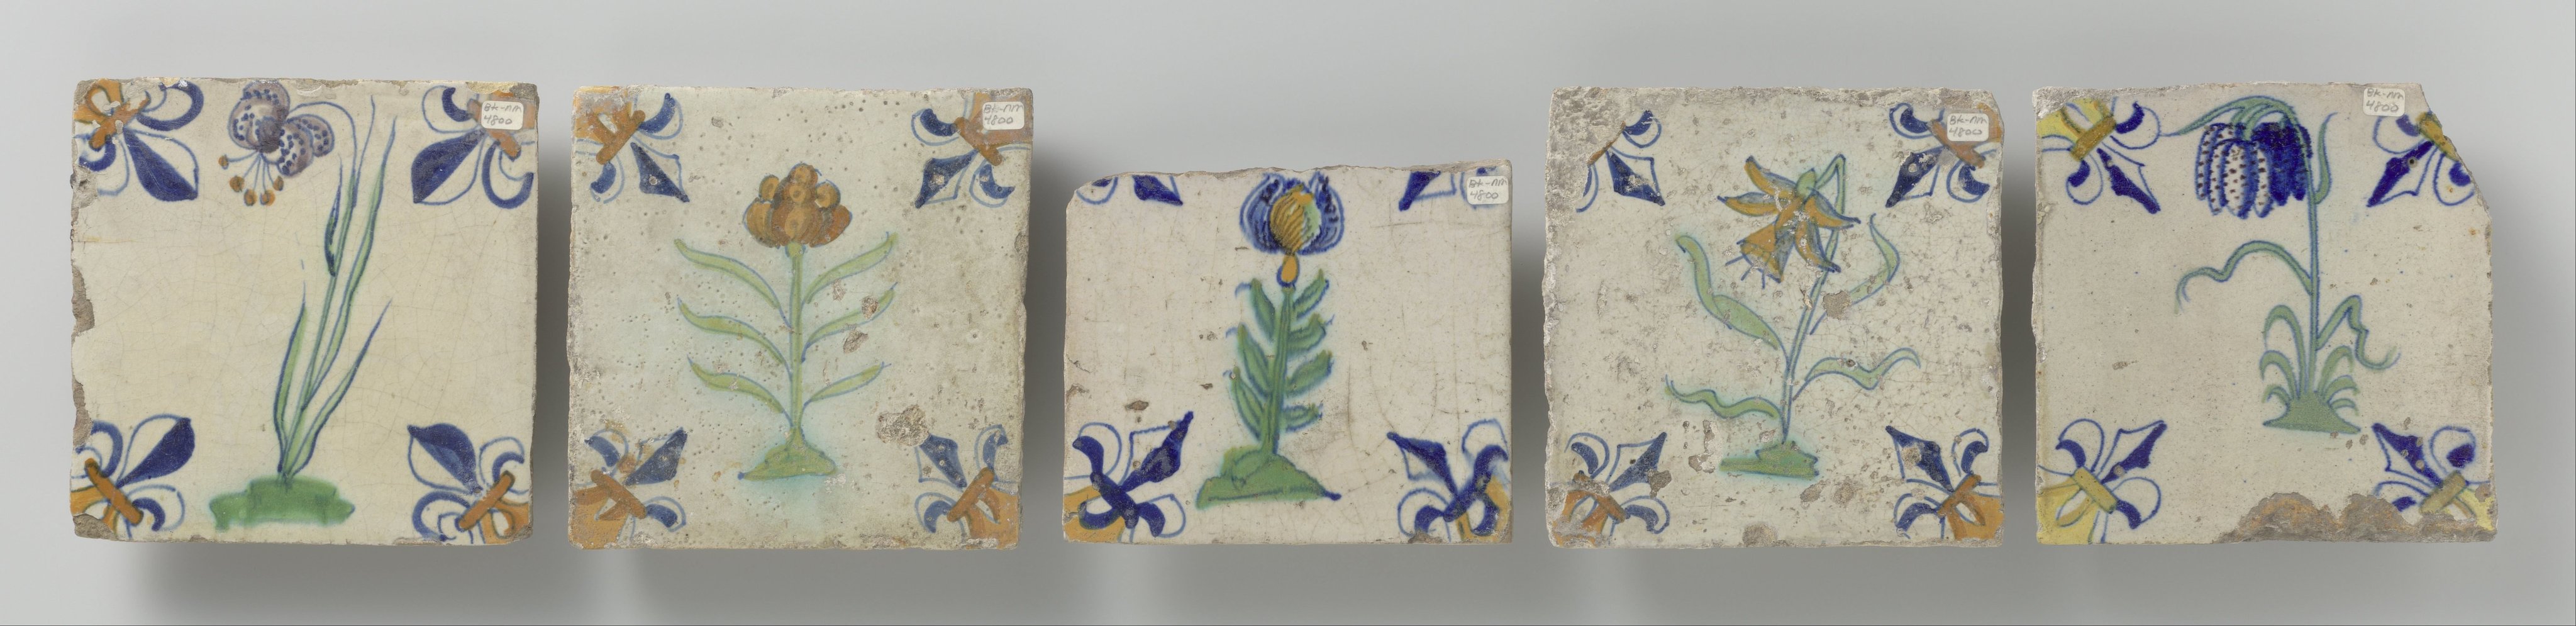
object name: tile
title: Vijf veelkleurige tegels met bloemen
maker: Anonymous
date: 1620-1650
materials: earthenware, glaze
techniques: maiolica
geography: netherlands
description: Vijf tegels met een bloem in de kleuren blauw, groen, geel en oranje. Het hoekmotief is een Franse lelie. Oorspronkelijk zijn er zestien tegels geweest.